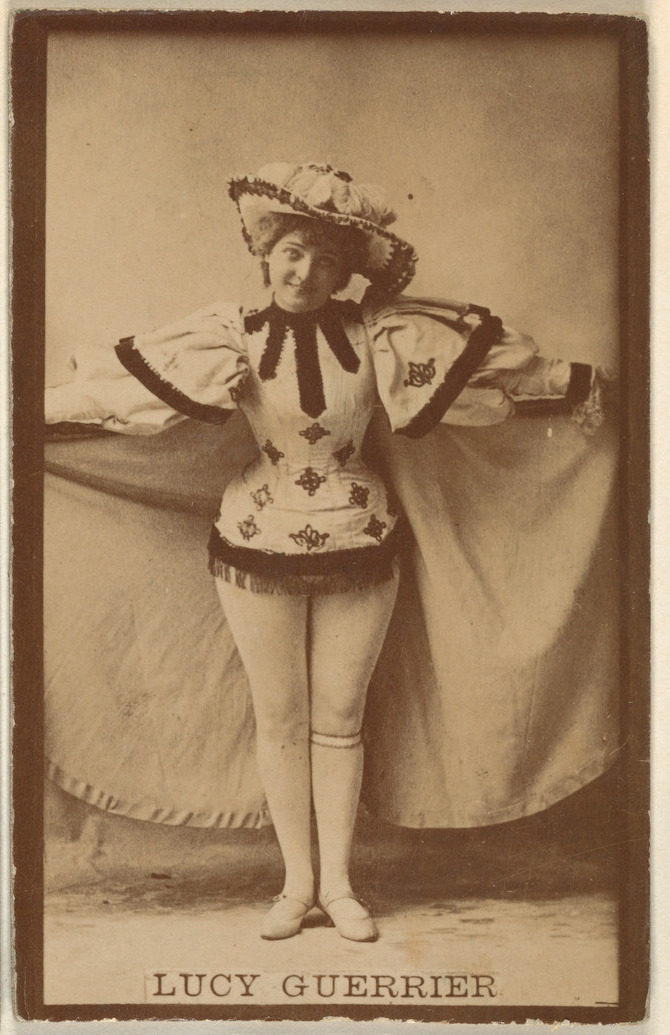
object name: photograph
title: Lucy Guerrier, from the Actresses series (N668)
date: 1888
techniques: albumen silver print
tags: portraits,women,actresses